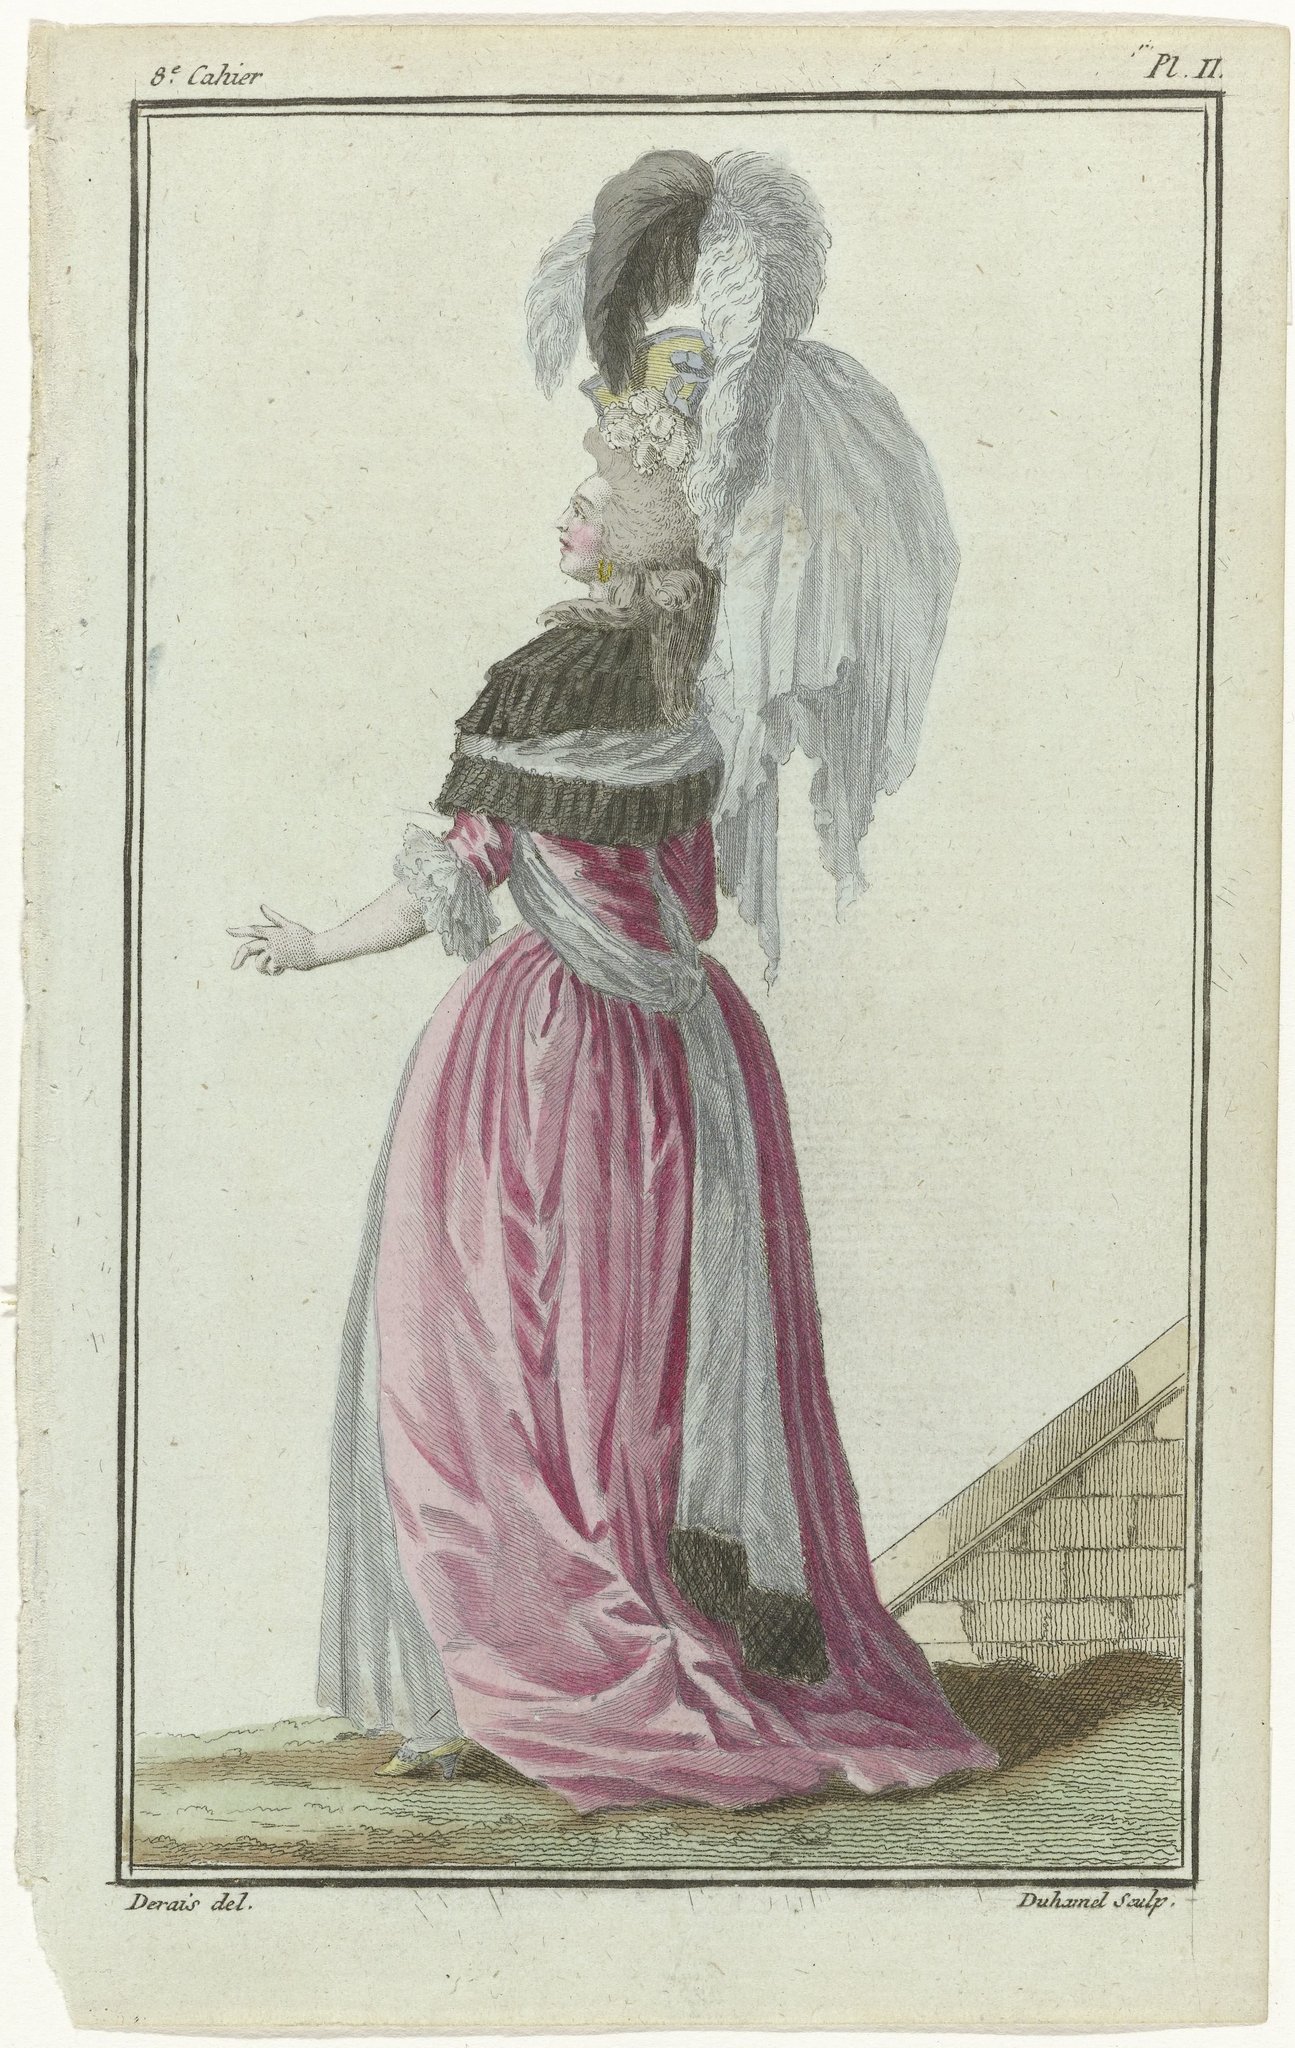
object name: fashion print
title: Cabinet des Modes ou les Modes Nouvelles, 1 mars 1786, Pl. II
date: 1786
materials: paper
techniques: engraving, hand coloring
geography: paris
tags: ear-rings (+ women's clothes), clothing for the upper part of the body (shawl) (+ women's clothes), border, ribbon, braid (+ women's clothes), underclothes for the lower part of the body (underskirt) (+ women's clothes), dress, gown: robe à l'anglaise (+ women's clothes), belt, girdle, waistband (+ variant), head-gear (+ women's clothes), styles of hairdress - aa - ~ women, fashion plates, shoes, sandals (+ women's clothes)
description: Robe à l'anglaise. Volgens de begeleidende tekst is de japon van licht roze satijn en de onderrok van licht wit satijn. Hier over een zeer grote sjaal van witte tafzijde versierd met een grote falbala van zwarte tule, in plaats van een mantel. De sjaal is over de borst gedrapeerd, aan de achterzijde (over de japon) vastgeknoopt en vormt zo een ceintuur. De twee uiteinden zijn versierd met eenzelfde falbala of franje. Het haar hangt 'à la Conseillère' en heeft twee grote krullen die over de schouders vallen. Op het kapsel een 'casque à la Romaine' van geel satijn met drie grote veren. De casque is versierd met een toef witte tule, die van achteren tot op de ceintuur hangt. De prent maakt deel uit van het 8e Cahier uit het Cabinet des Modes ou les Modes Nouvelles. De serie bestaat uit 72 modeprenten, uitgegeven door Buisson, Parijs, 15 november 1785 - 1 november 1786.